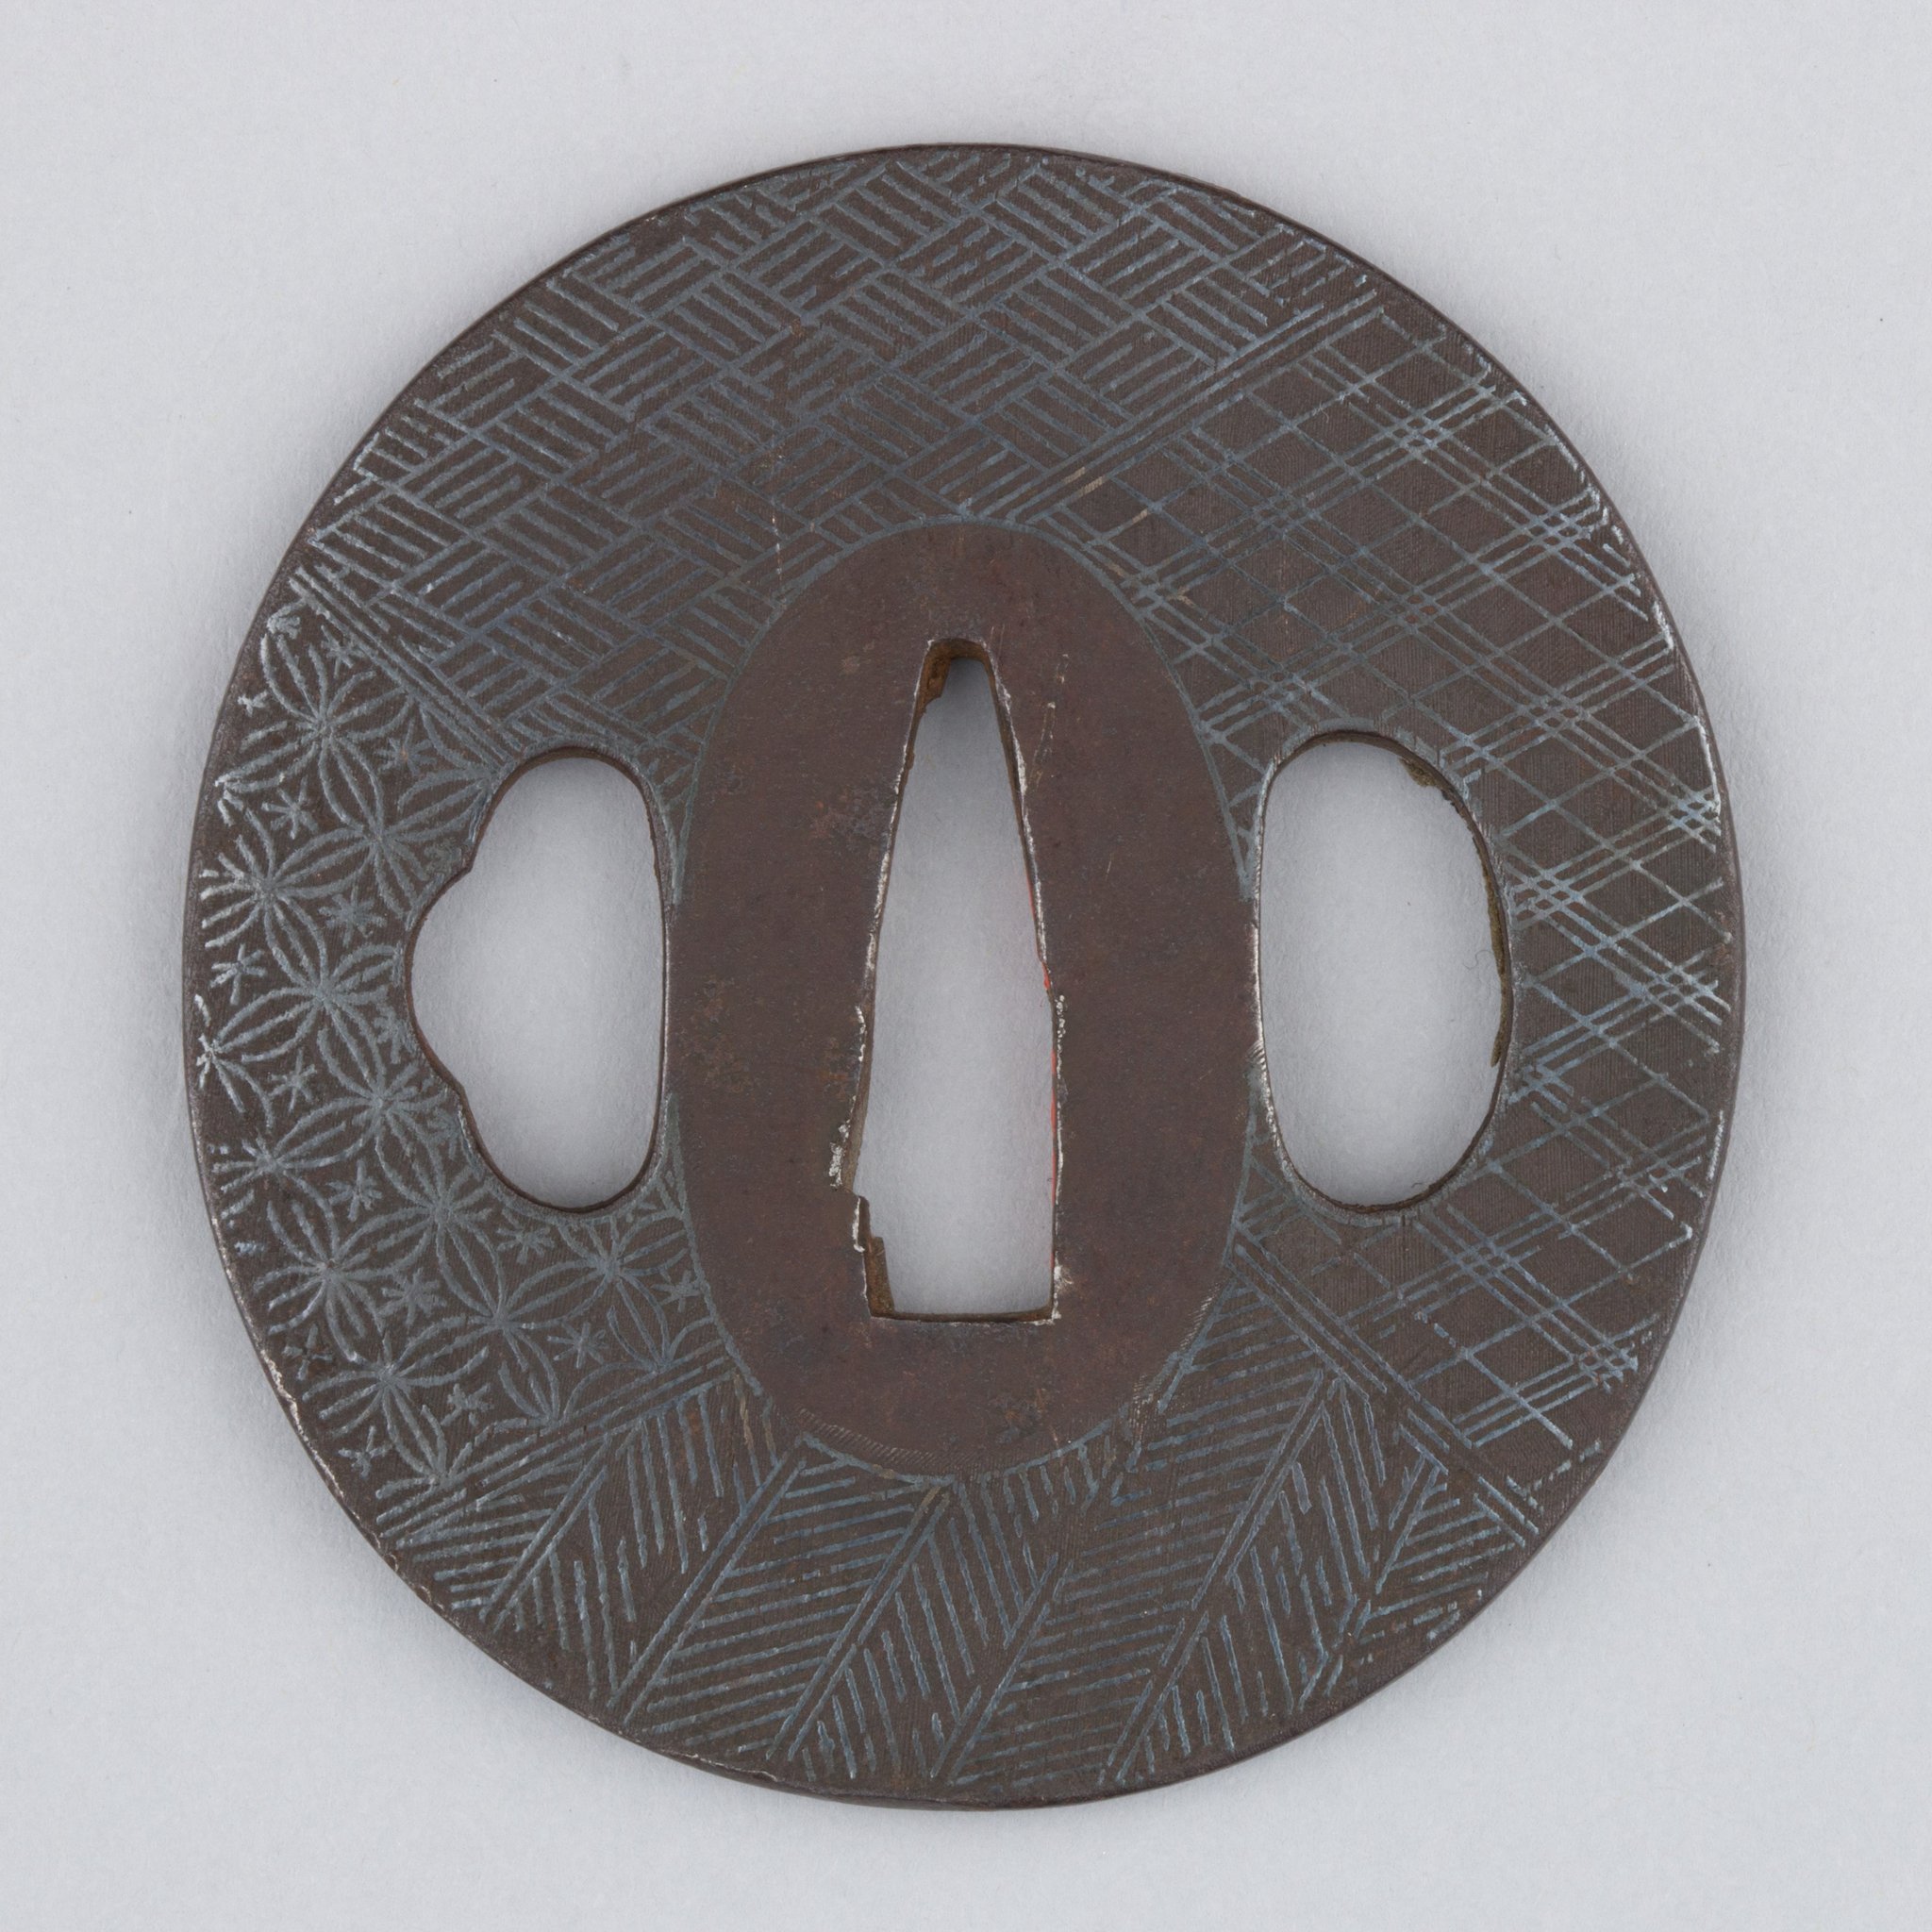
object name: sword guard tsuba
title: Sword Guard (Tsuba)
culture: japanese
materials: copper, iron, silver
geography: japan